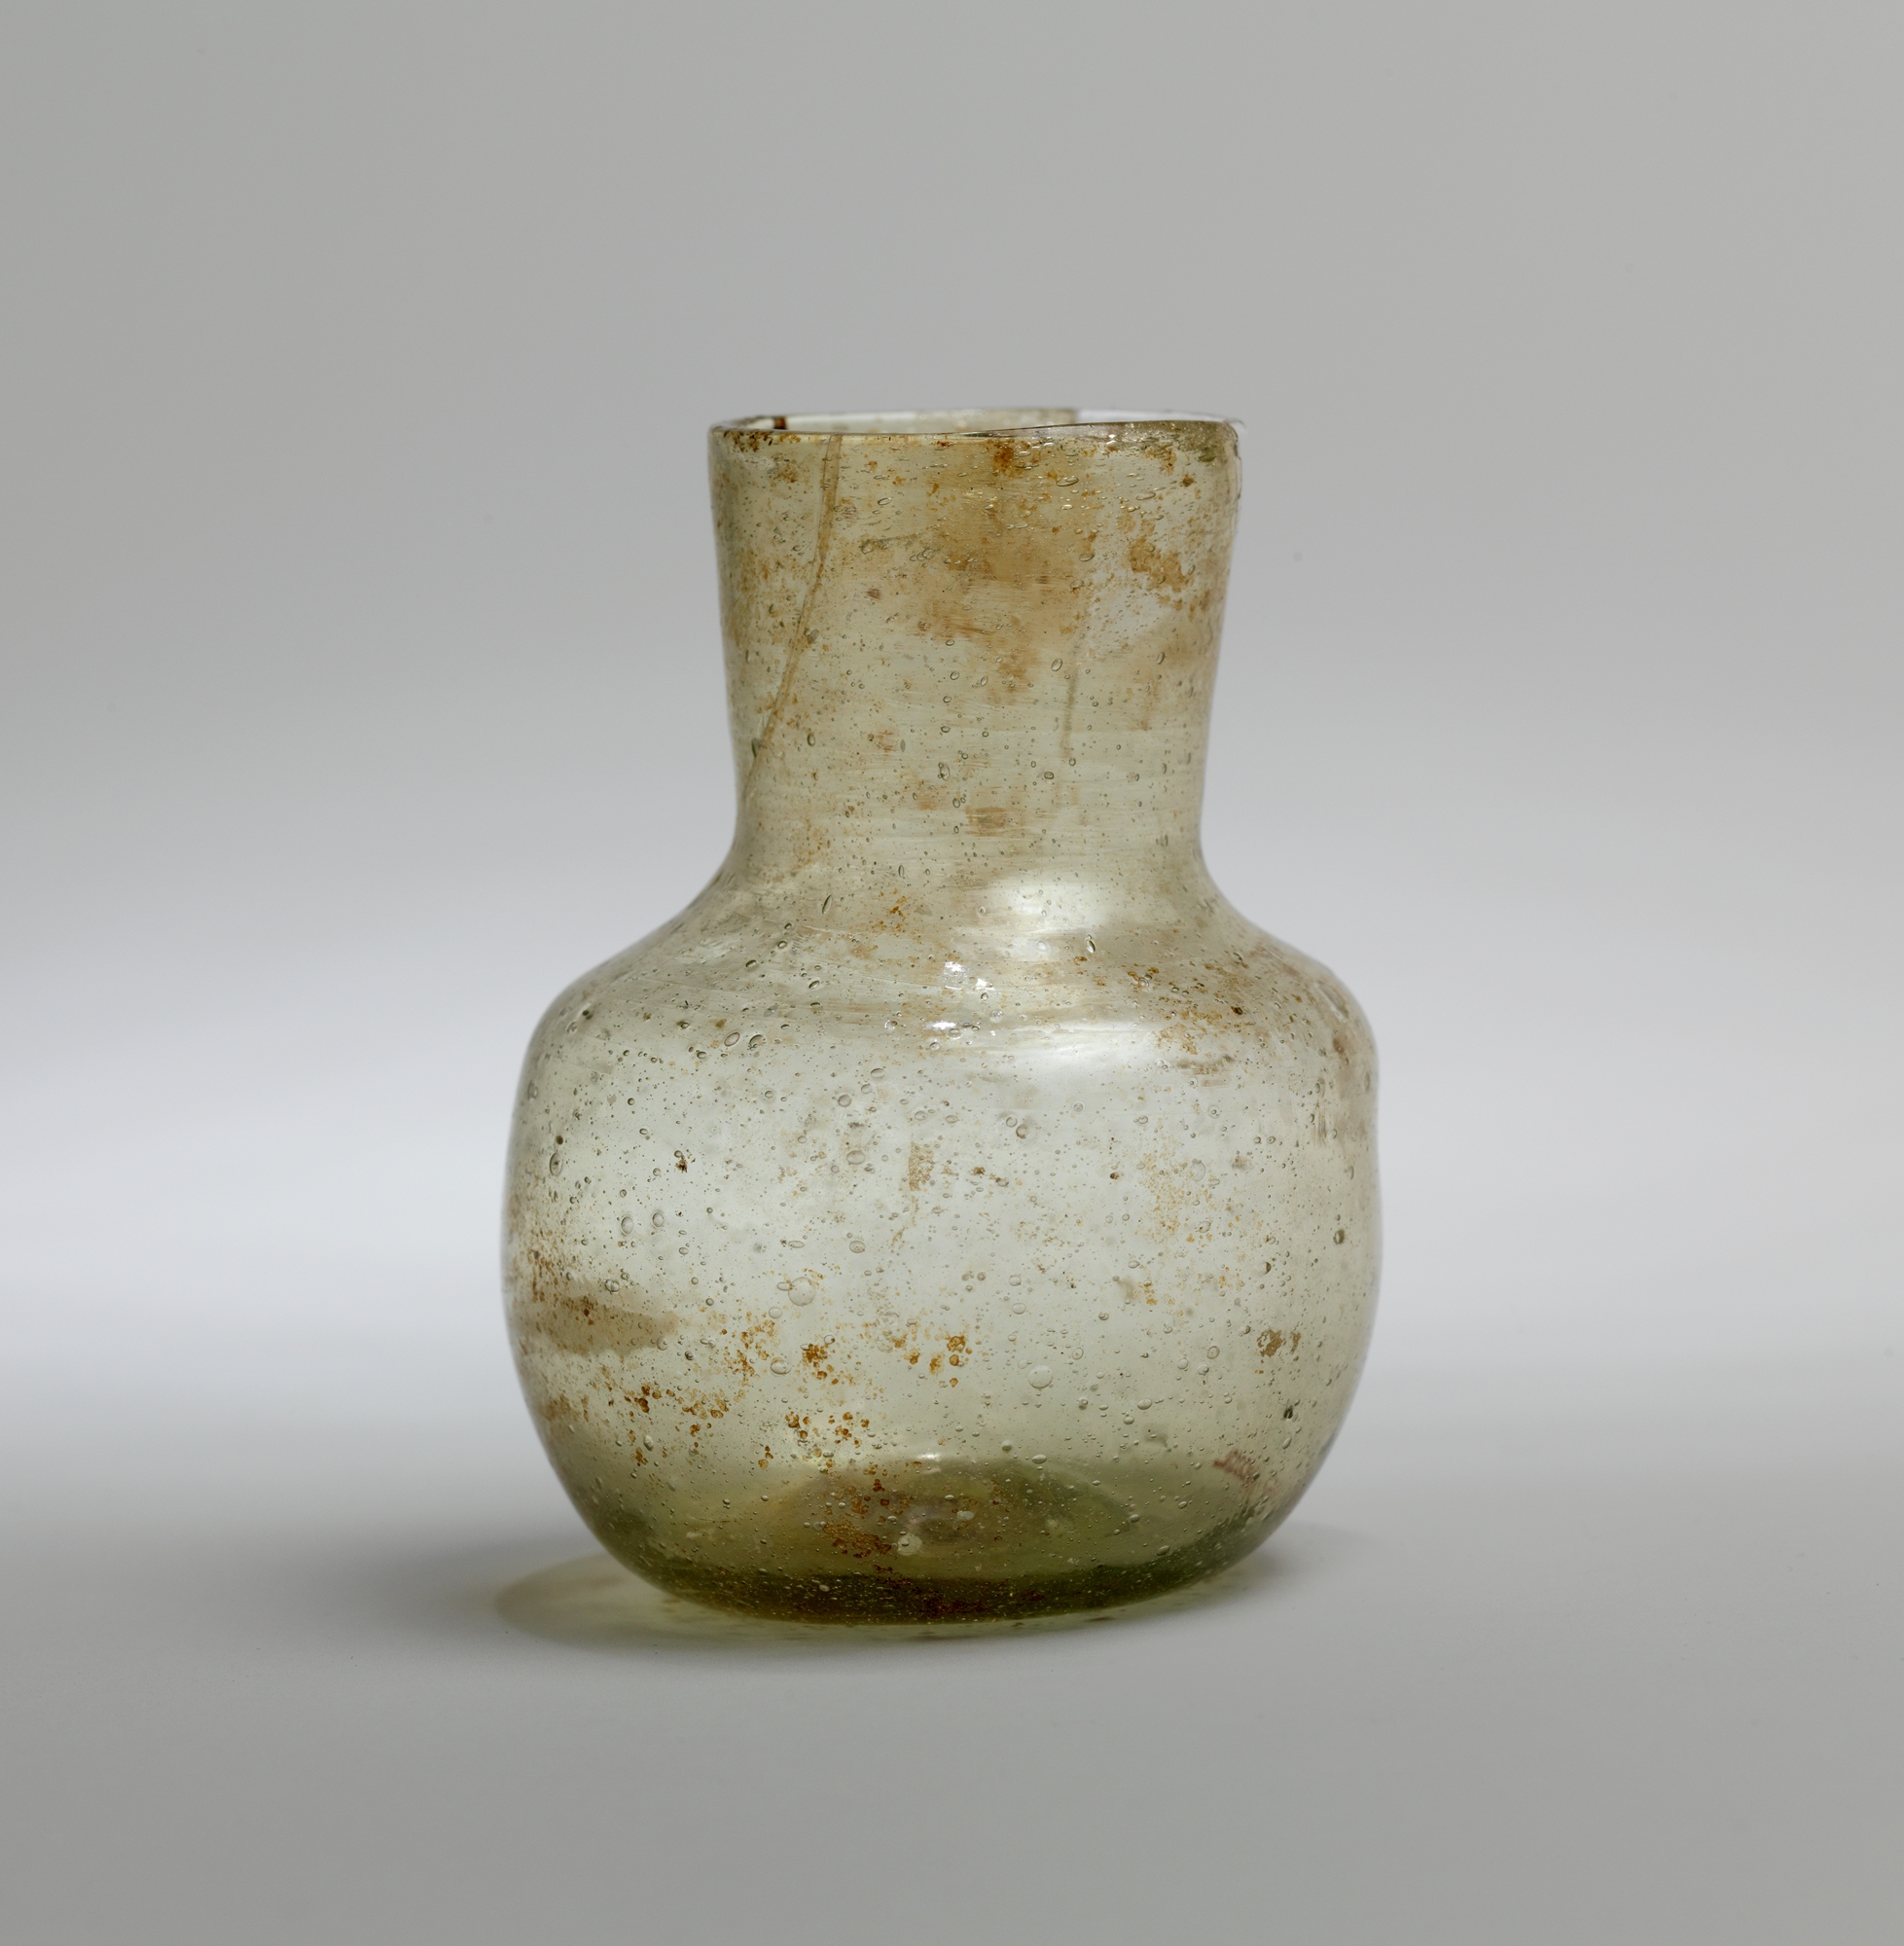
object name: bottle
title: Miniature Glass Bottle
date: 801-900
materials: glass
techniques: glassblowing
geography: iran